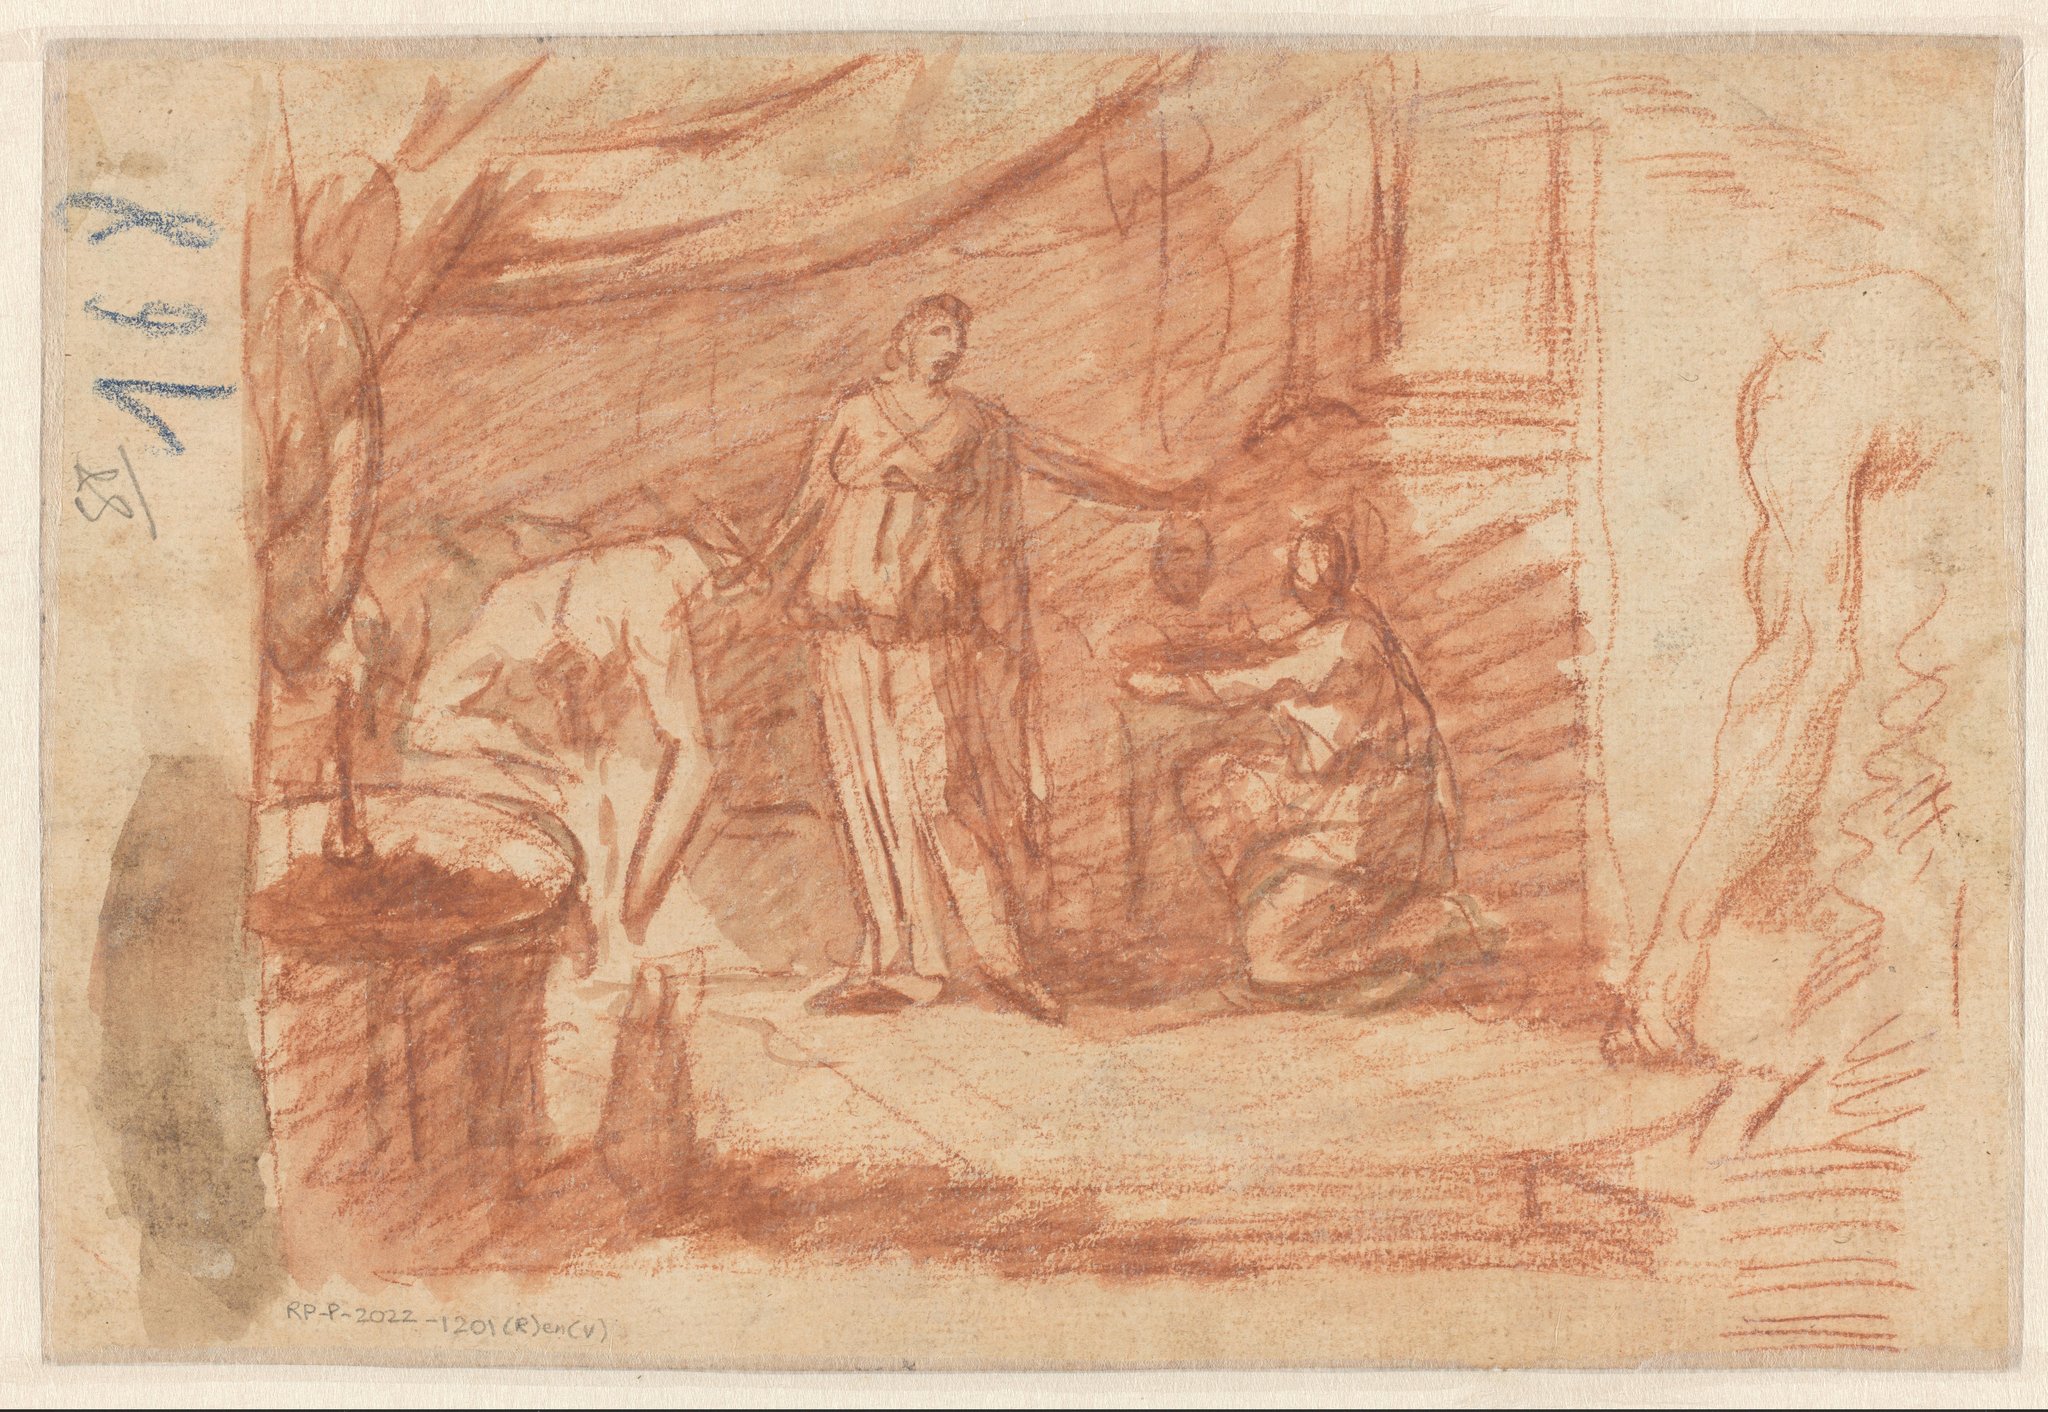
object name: print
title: Berenjacht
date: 1600-1649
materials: paper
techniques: engraving